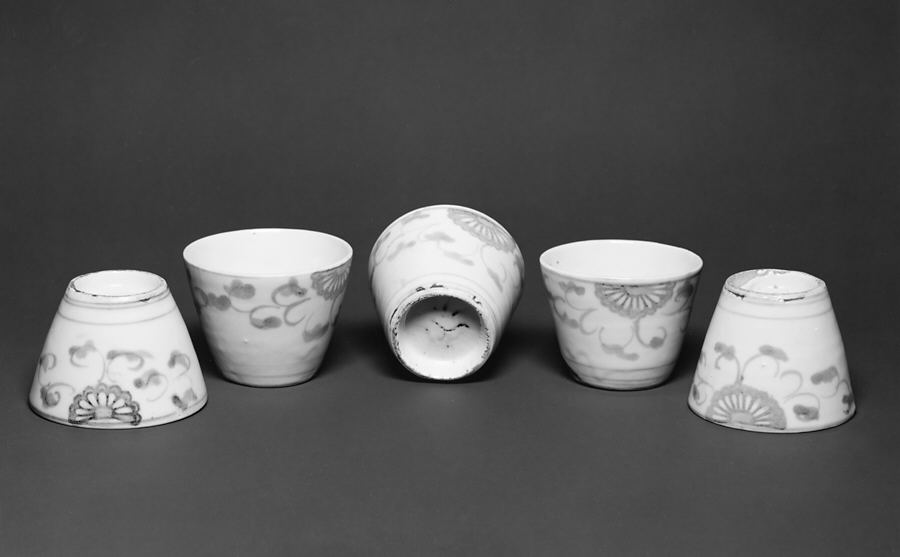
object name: soba cup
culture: japanese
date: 1801-1900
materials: cobalt, porcelain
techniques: painting, underglaze